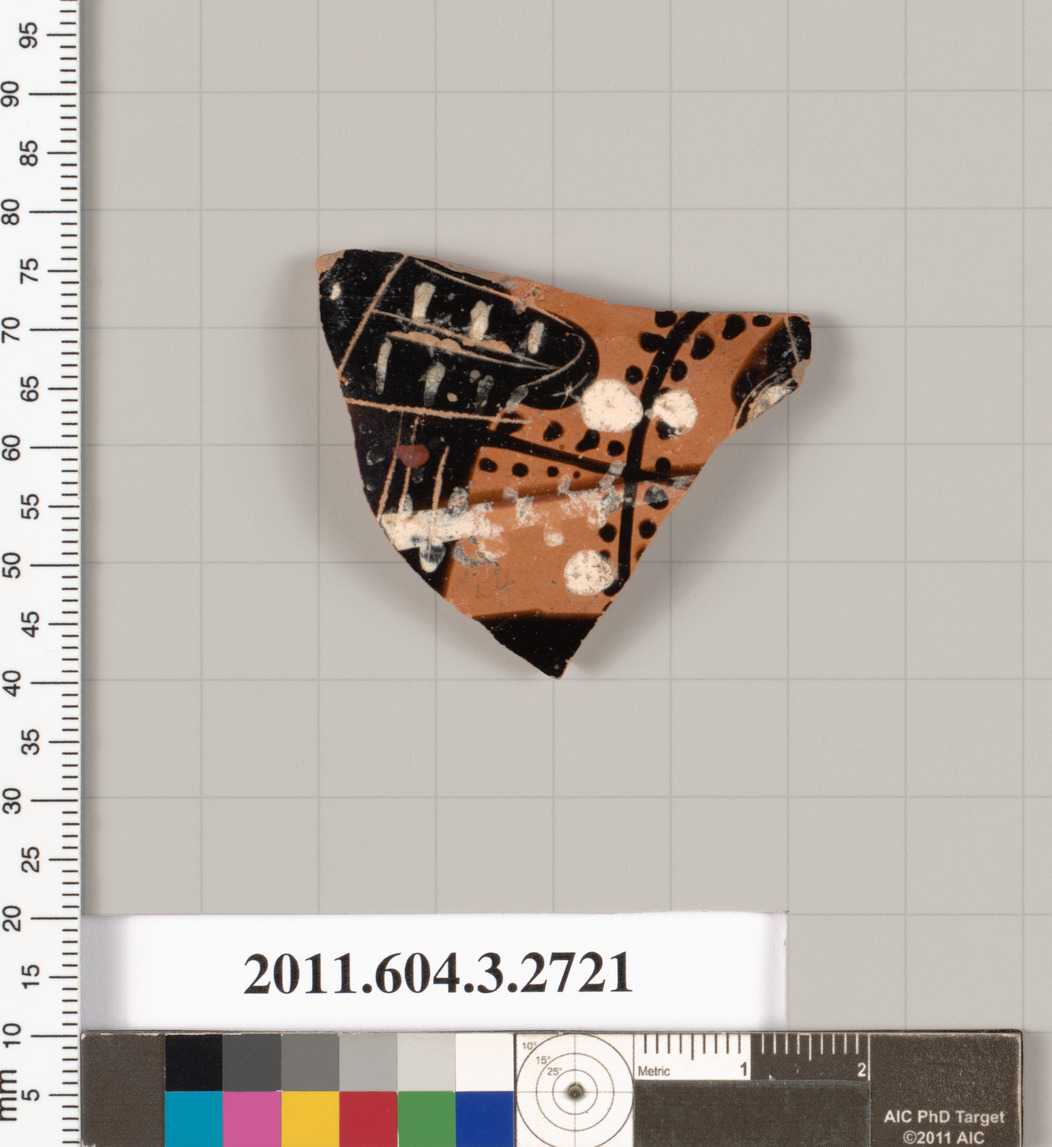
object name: oinochoe fragment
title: Terracotta fragment of an oinochoe (jug)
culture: greek, attic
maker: red-line painter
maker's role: artist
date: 510-500 BCE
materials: terracotta